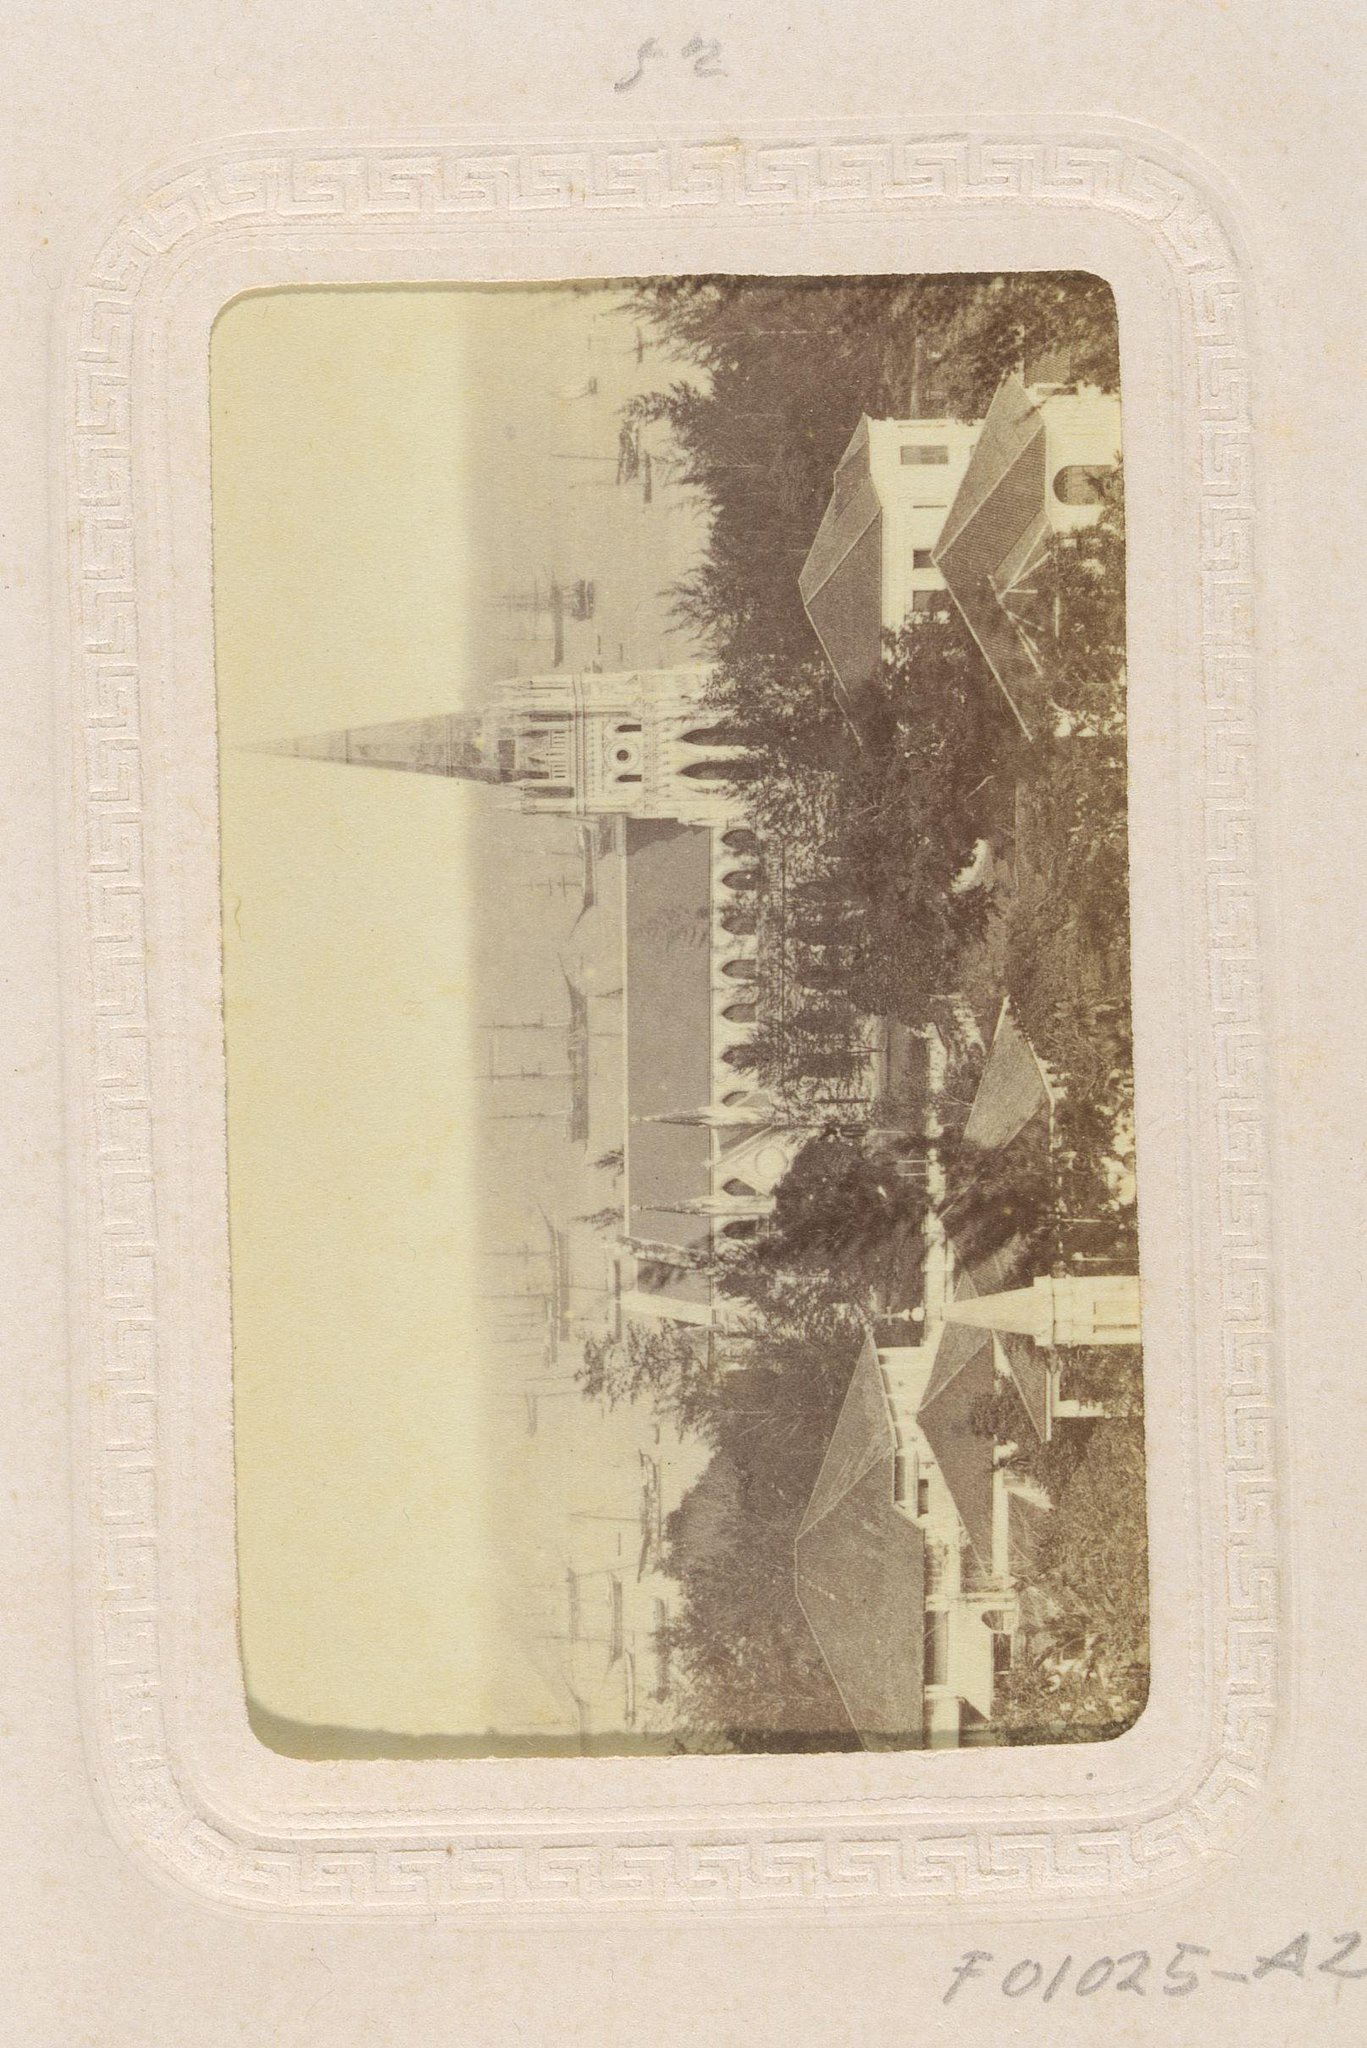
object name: album leaf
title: Gezicht op Singapore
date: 1867-1880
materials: cardboard, photographic support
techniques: albumen print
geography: singapore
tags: city-view in general; 'veduta', singapore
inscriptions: number: ‘52’, annotation: ‘gezigt van Singapore’, inscription: ‘G.R. Lambert & Co./ Photographers/ Singapore’